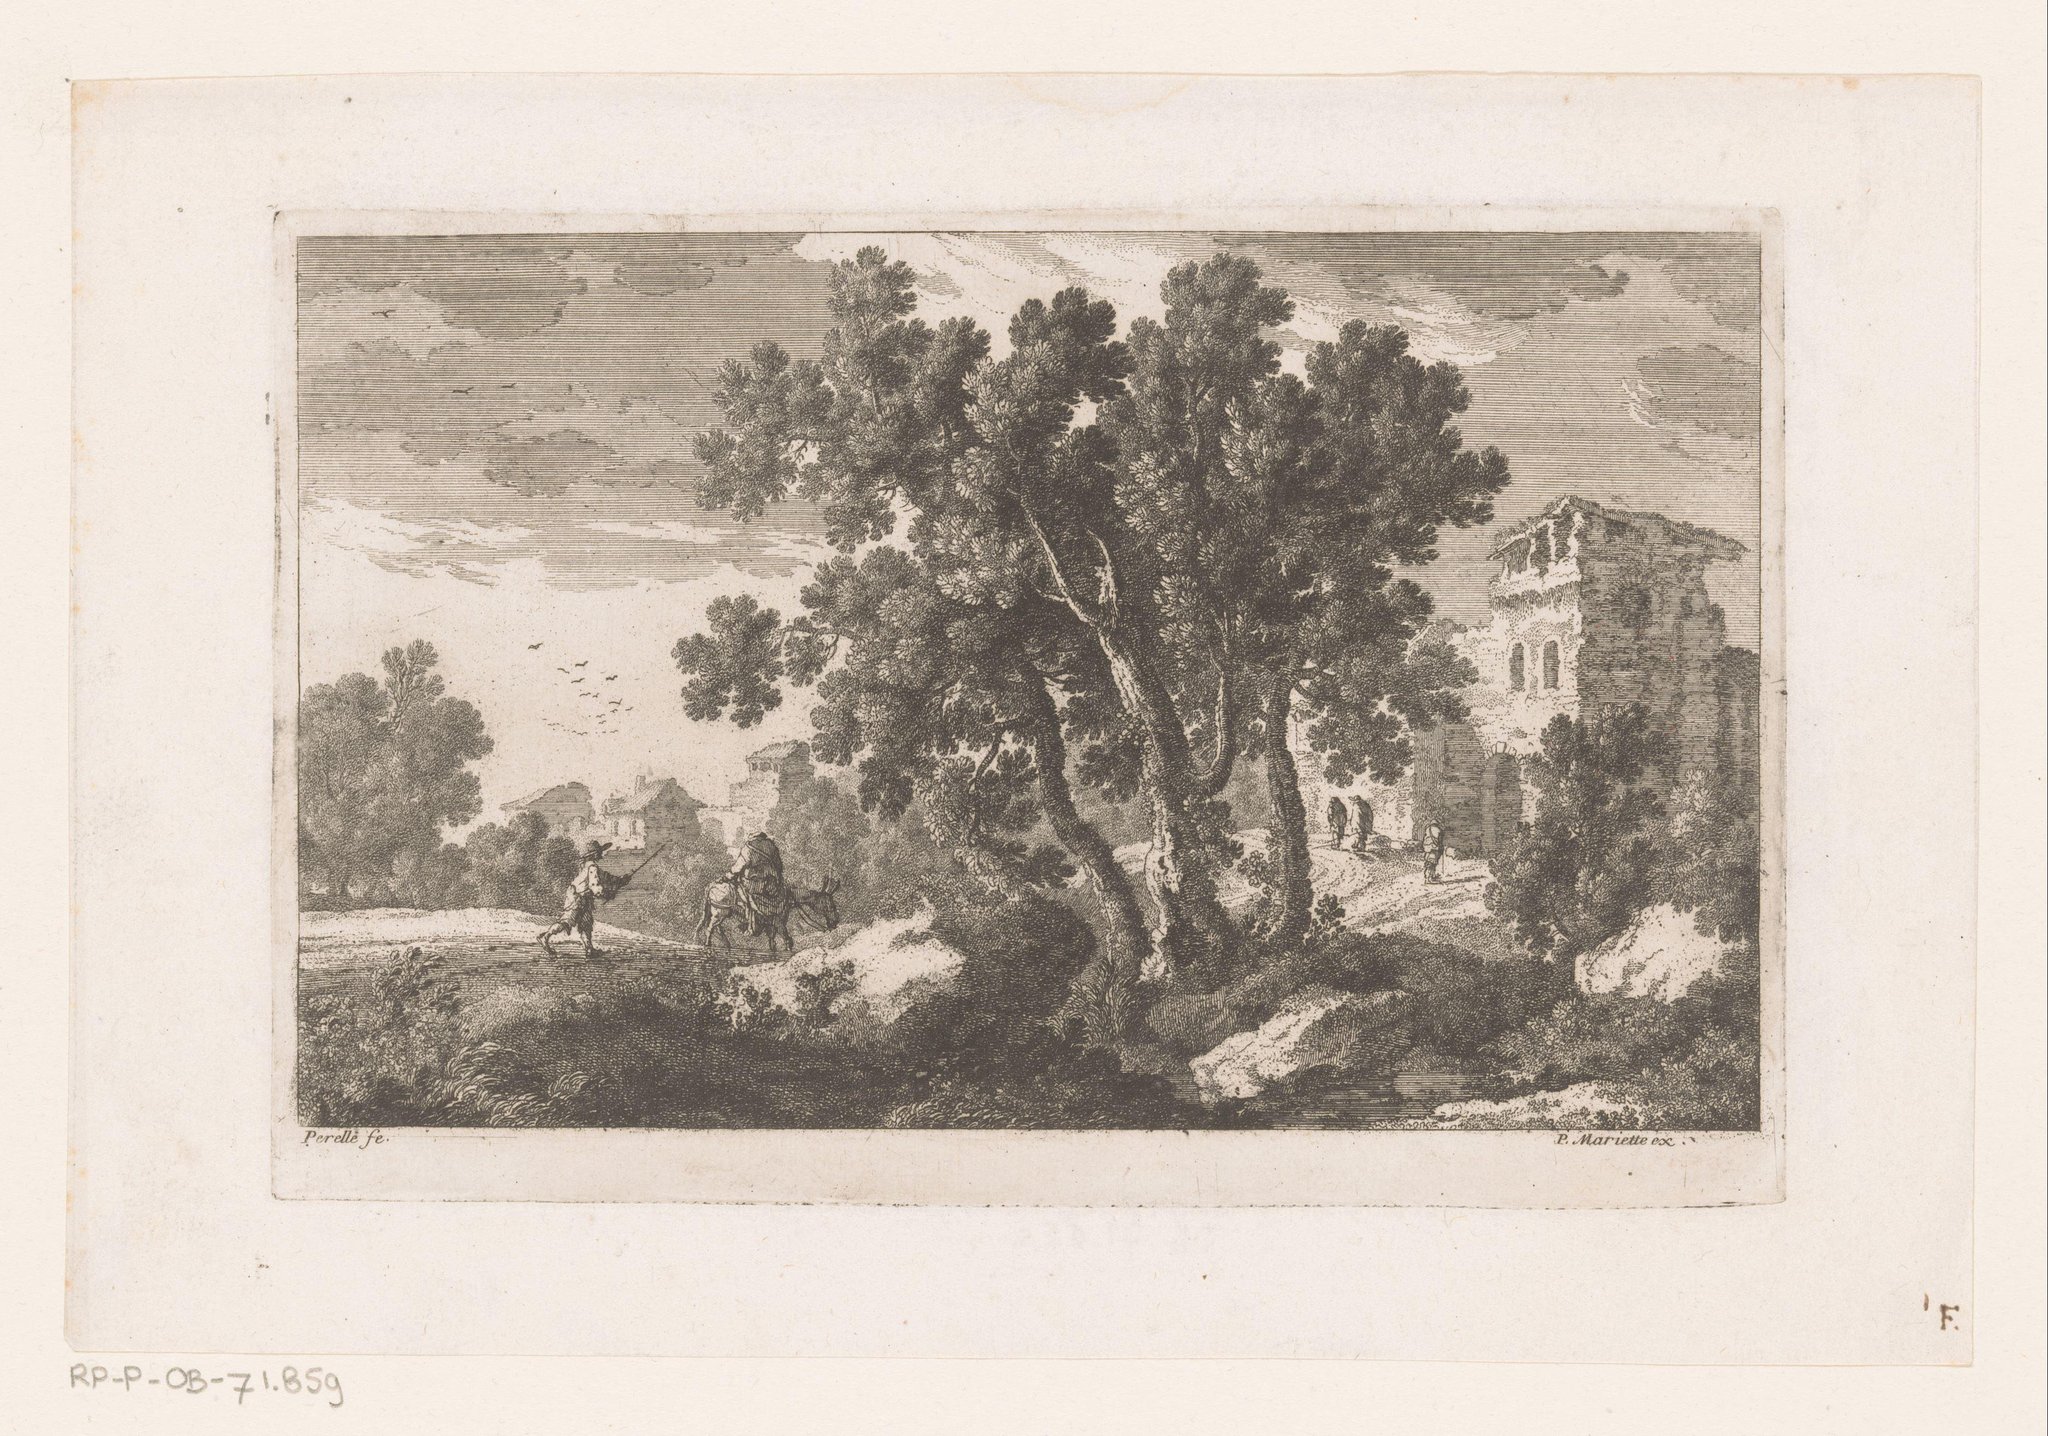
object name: print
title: Landschap met figuur op lastdier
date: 1613-1695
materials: paper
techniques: engraving, etching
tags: riding a horse, ass, or mule; rider, horseman, landscapes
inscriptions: collector's mark: Lugt 240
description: Prenten met het signatuur 'Perelle' kunnen zowel door vader Gabriel als door zonen Nicolas en Adam gemaakt zijn.